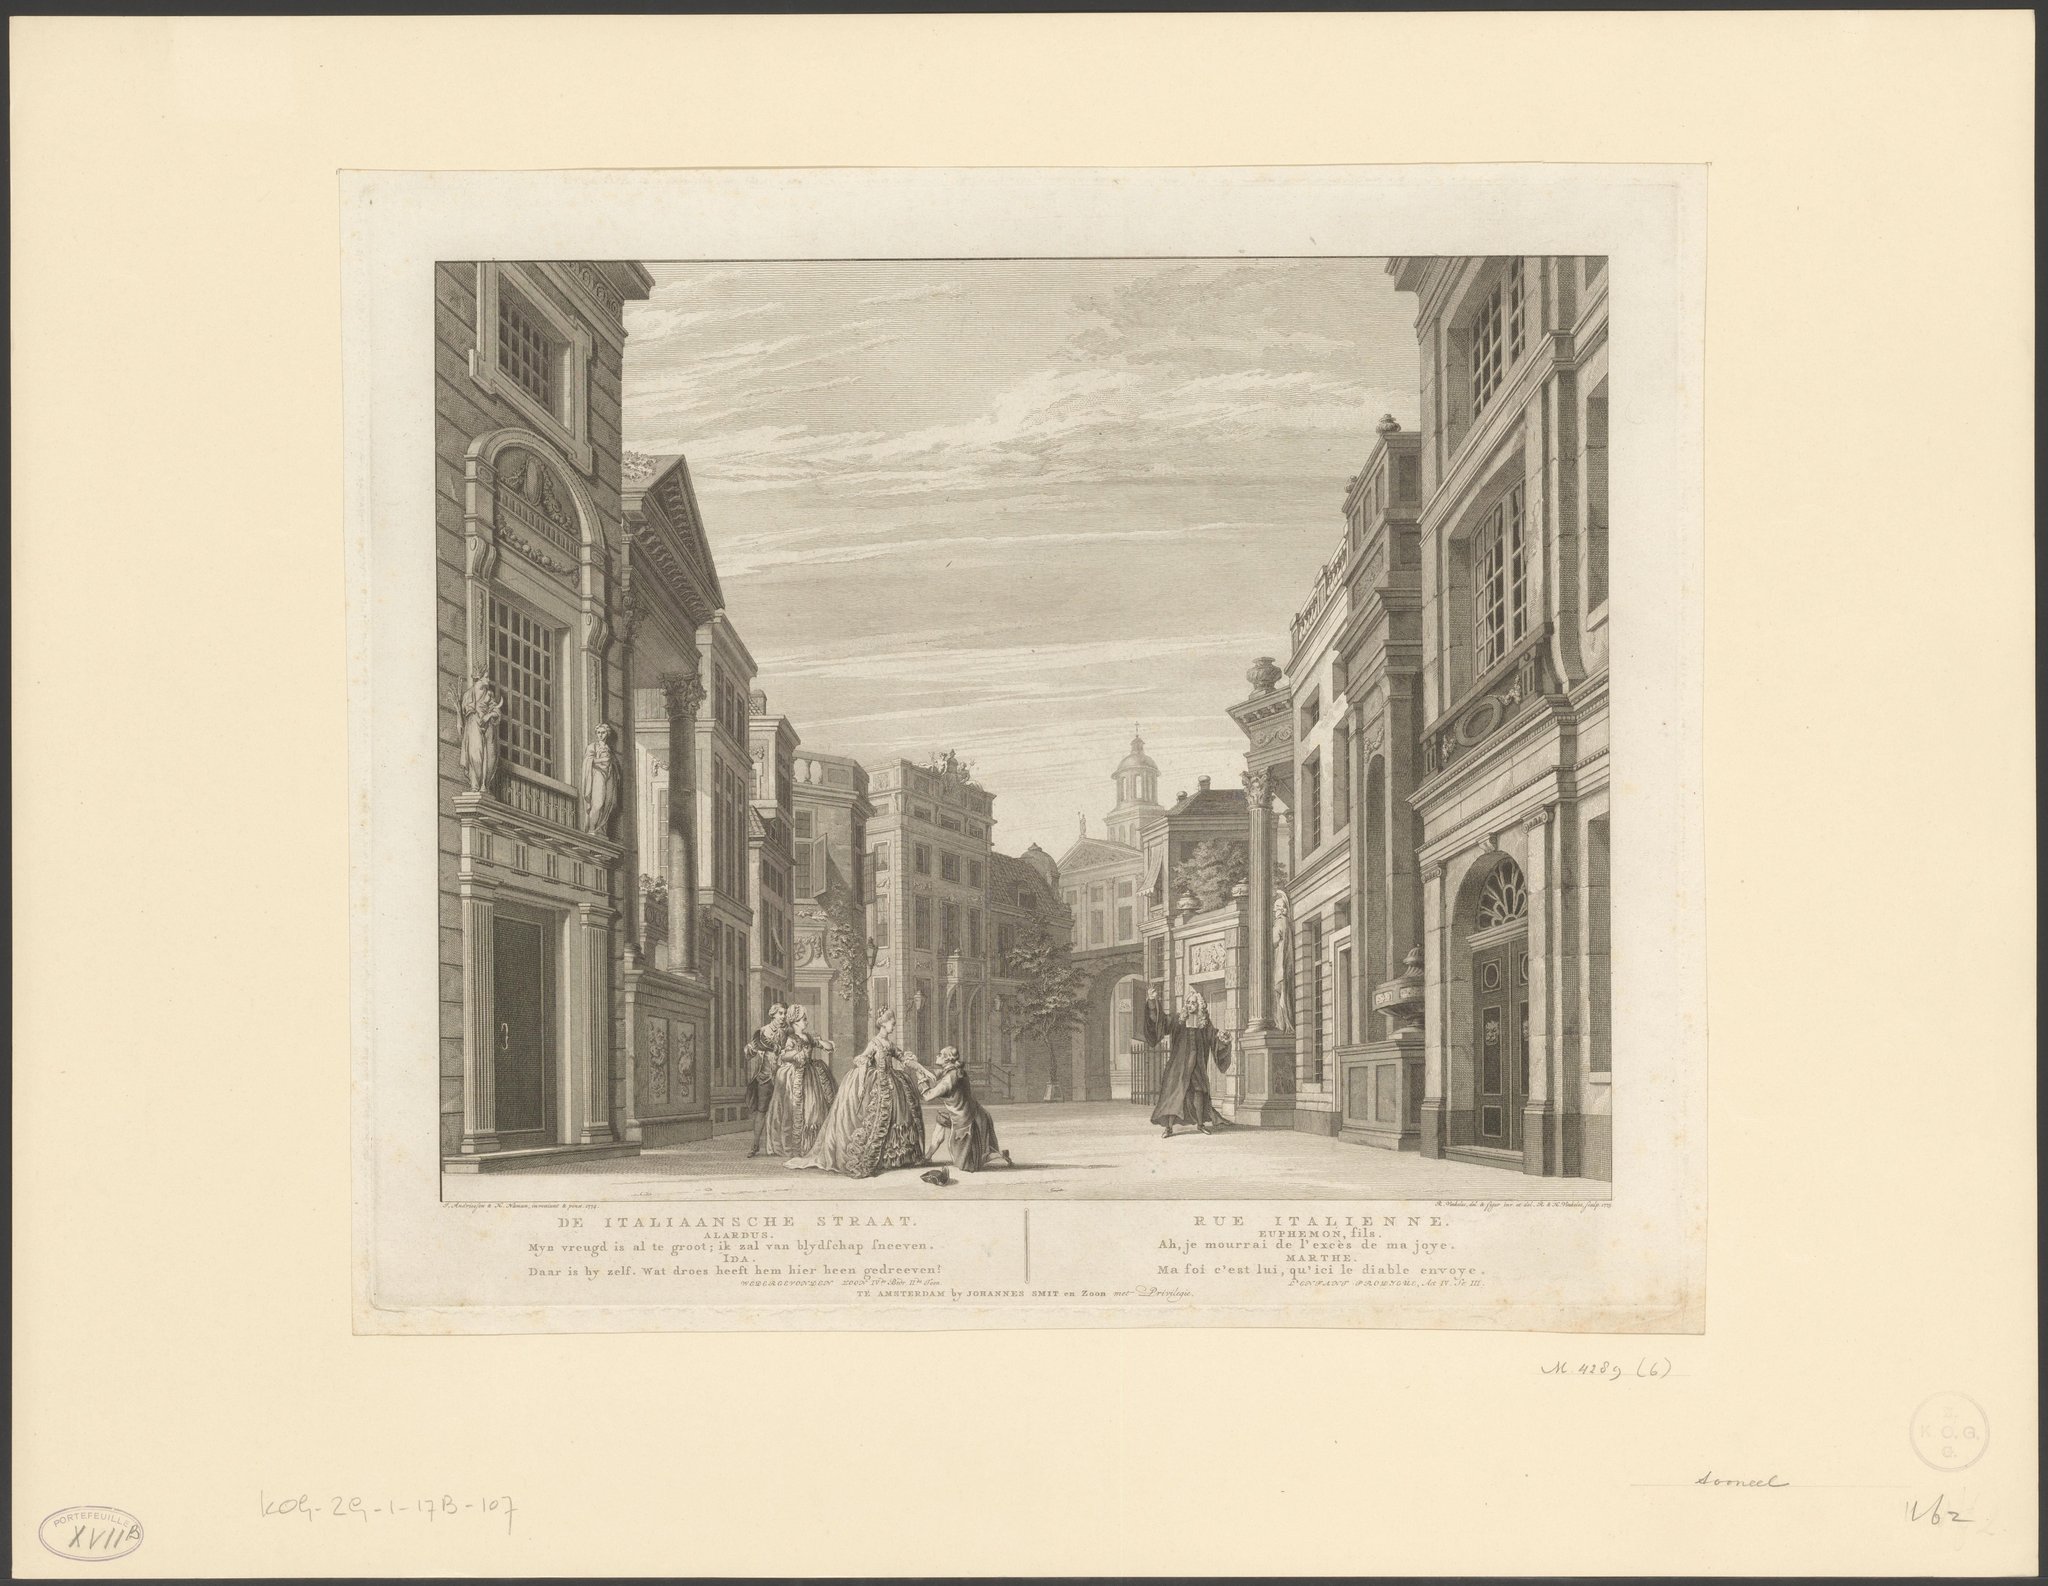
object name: print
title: Toneeldecor: De Italiaansche Straat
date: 1775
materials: paper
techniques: engraving, etching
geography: amsterdam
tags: theatre, theatrical performance, stage design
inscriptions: collector's mark: Lugt 1641, stamp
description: Het coulissendecor De Italiaansche Straat, met een scène uit: Wedergevonden zoon. Onderdeel van een serie van zes toneeldecors van toneelstukken opgevoerd in de nieuwe Amsterdamse Schouwburg uit de jaren 1775-1777. Onderwerpsrubrieken binnen de Atlas Zeden en Gewoonten: Schoone kunsten, Tooneel, Decors voor de Schouwburg.